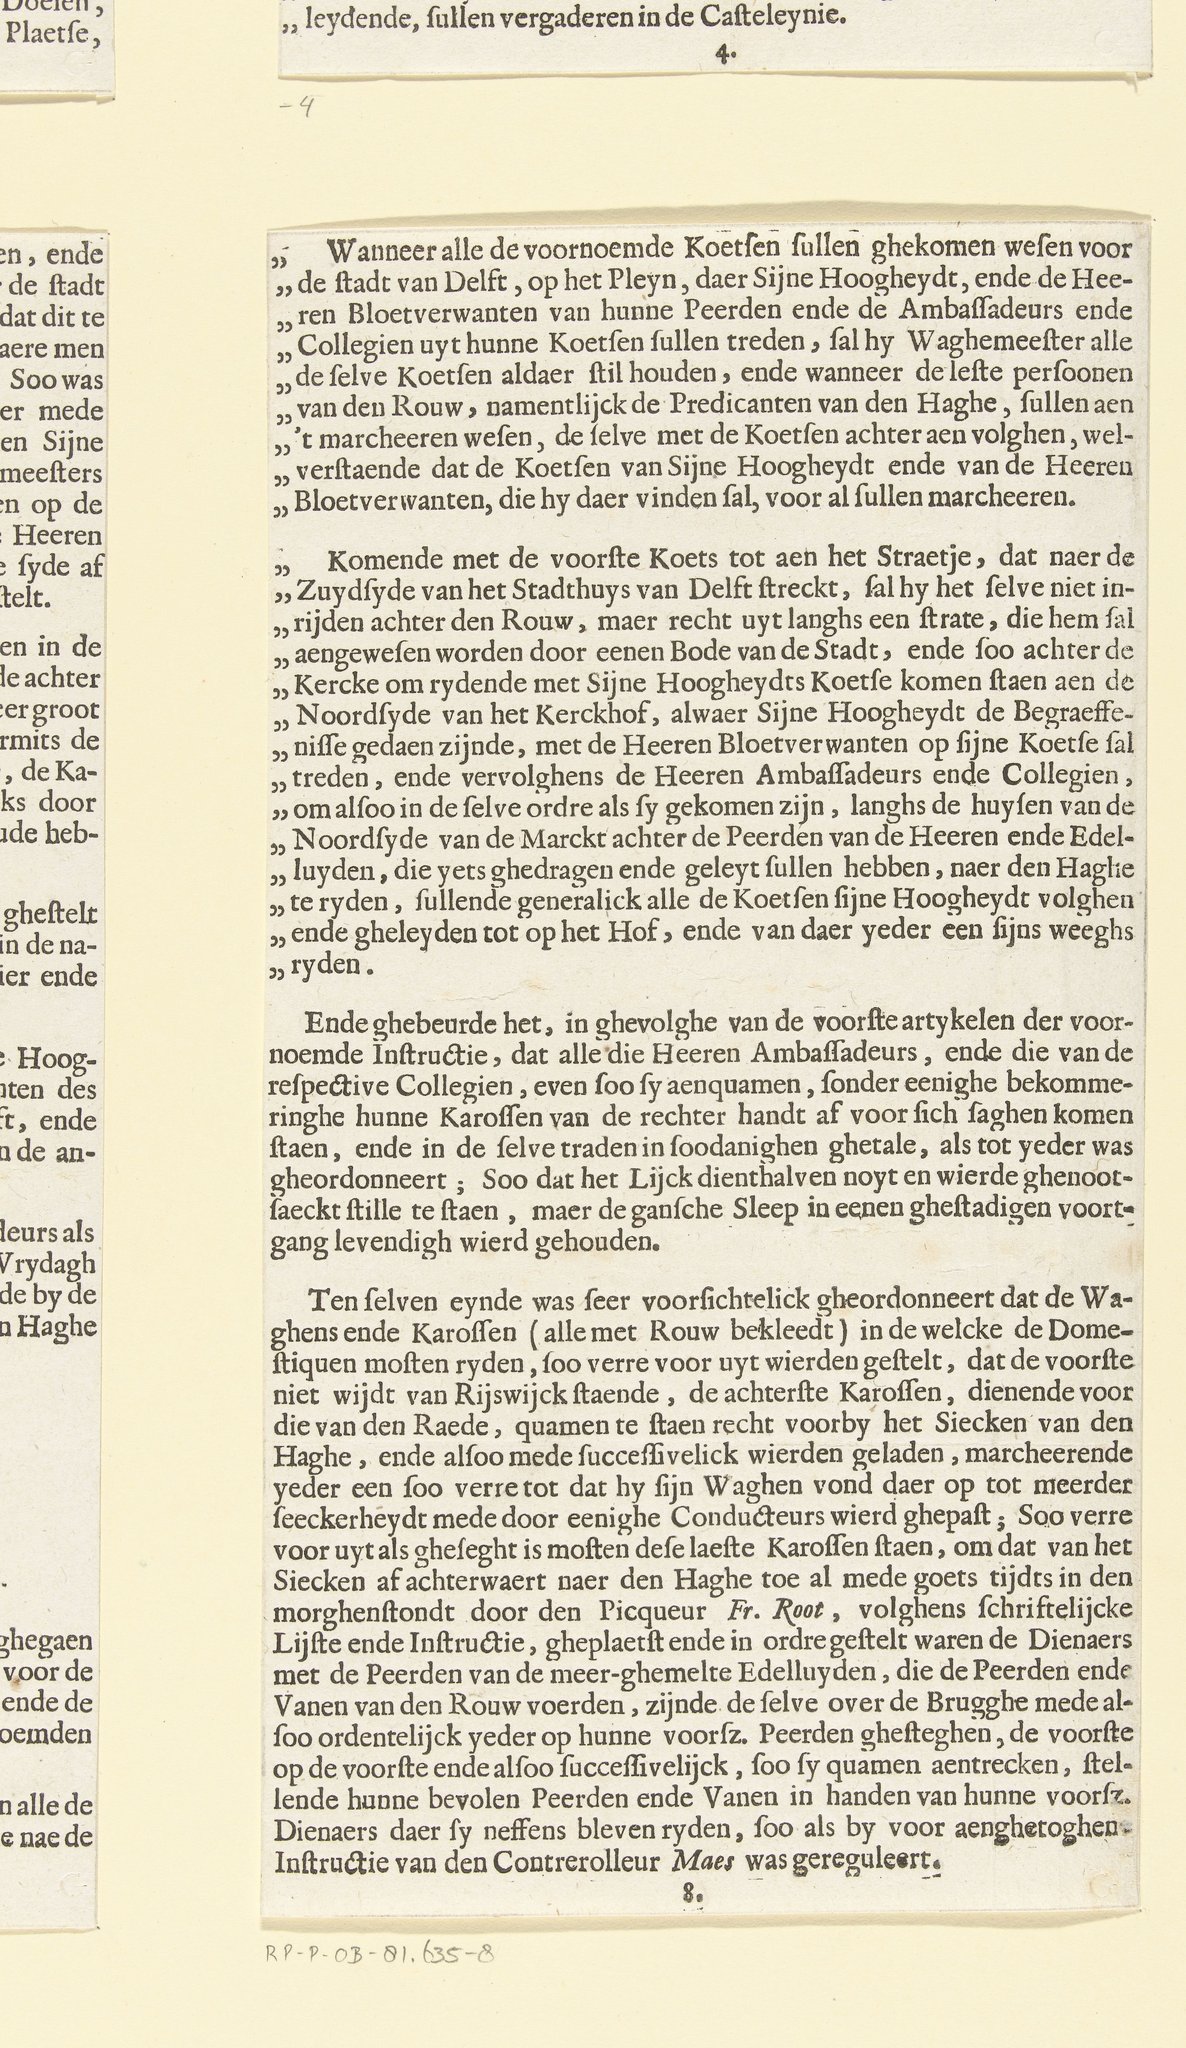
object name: text sheet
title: De begrafenisstoet van Frederik Hendrik (tekstblad 8), 1647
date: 1651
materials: paper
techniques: letterpress printing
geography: amsterdam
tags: delft, frederick henry (prince of orange), the hague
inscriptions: collector's mark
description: Tekstblad nr. 8 bij de prentserie van de begrafenisstoet van stadhouder Frederik Hendrik te 's-Gravenhage op 10 mei 1647. Onderdeel van een serie van 30 platen en 20 tekstbladen, bedoeld om aan elkaar geplakt te worden.